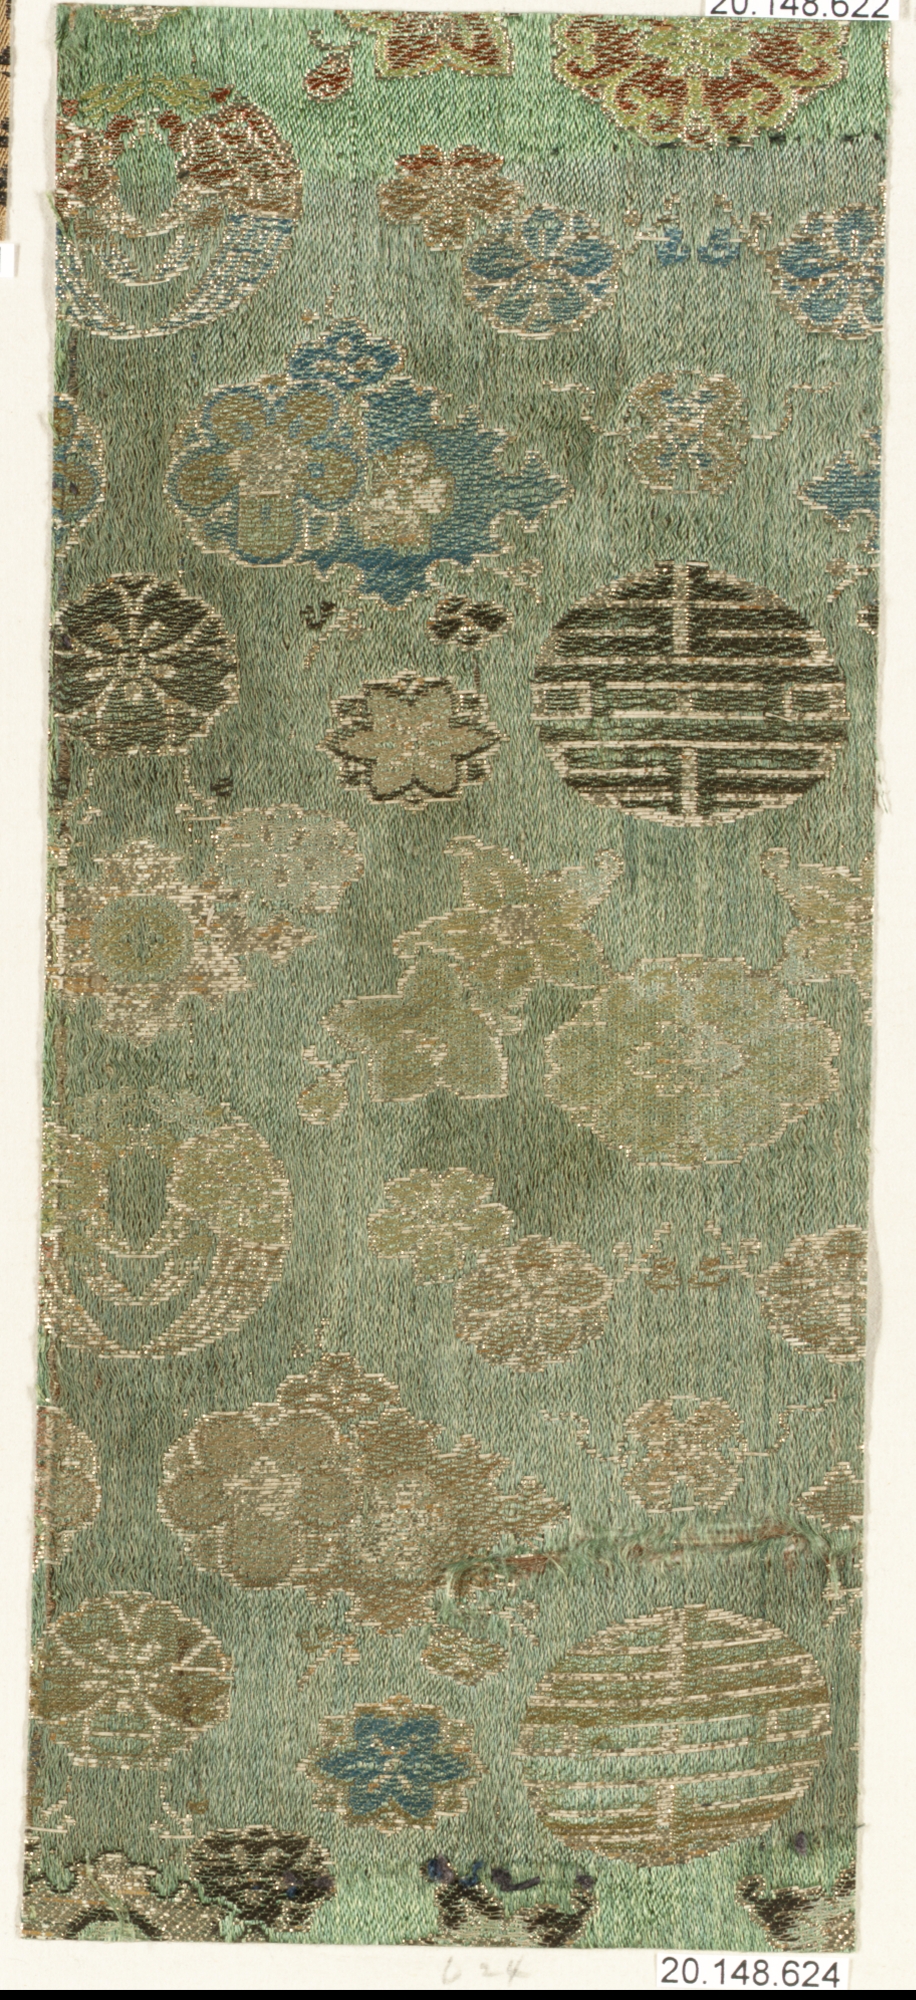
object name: piece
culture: japanese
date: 1601-1700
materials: silk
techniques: compound weave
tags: flowers